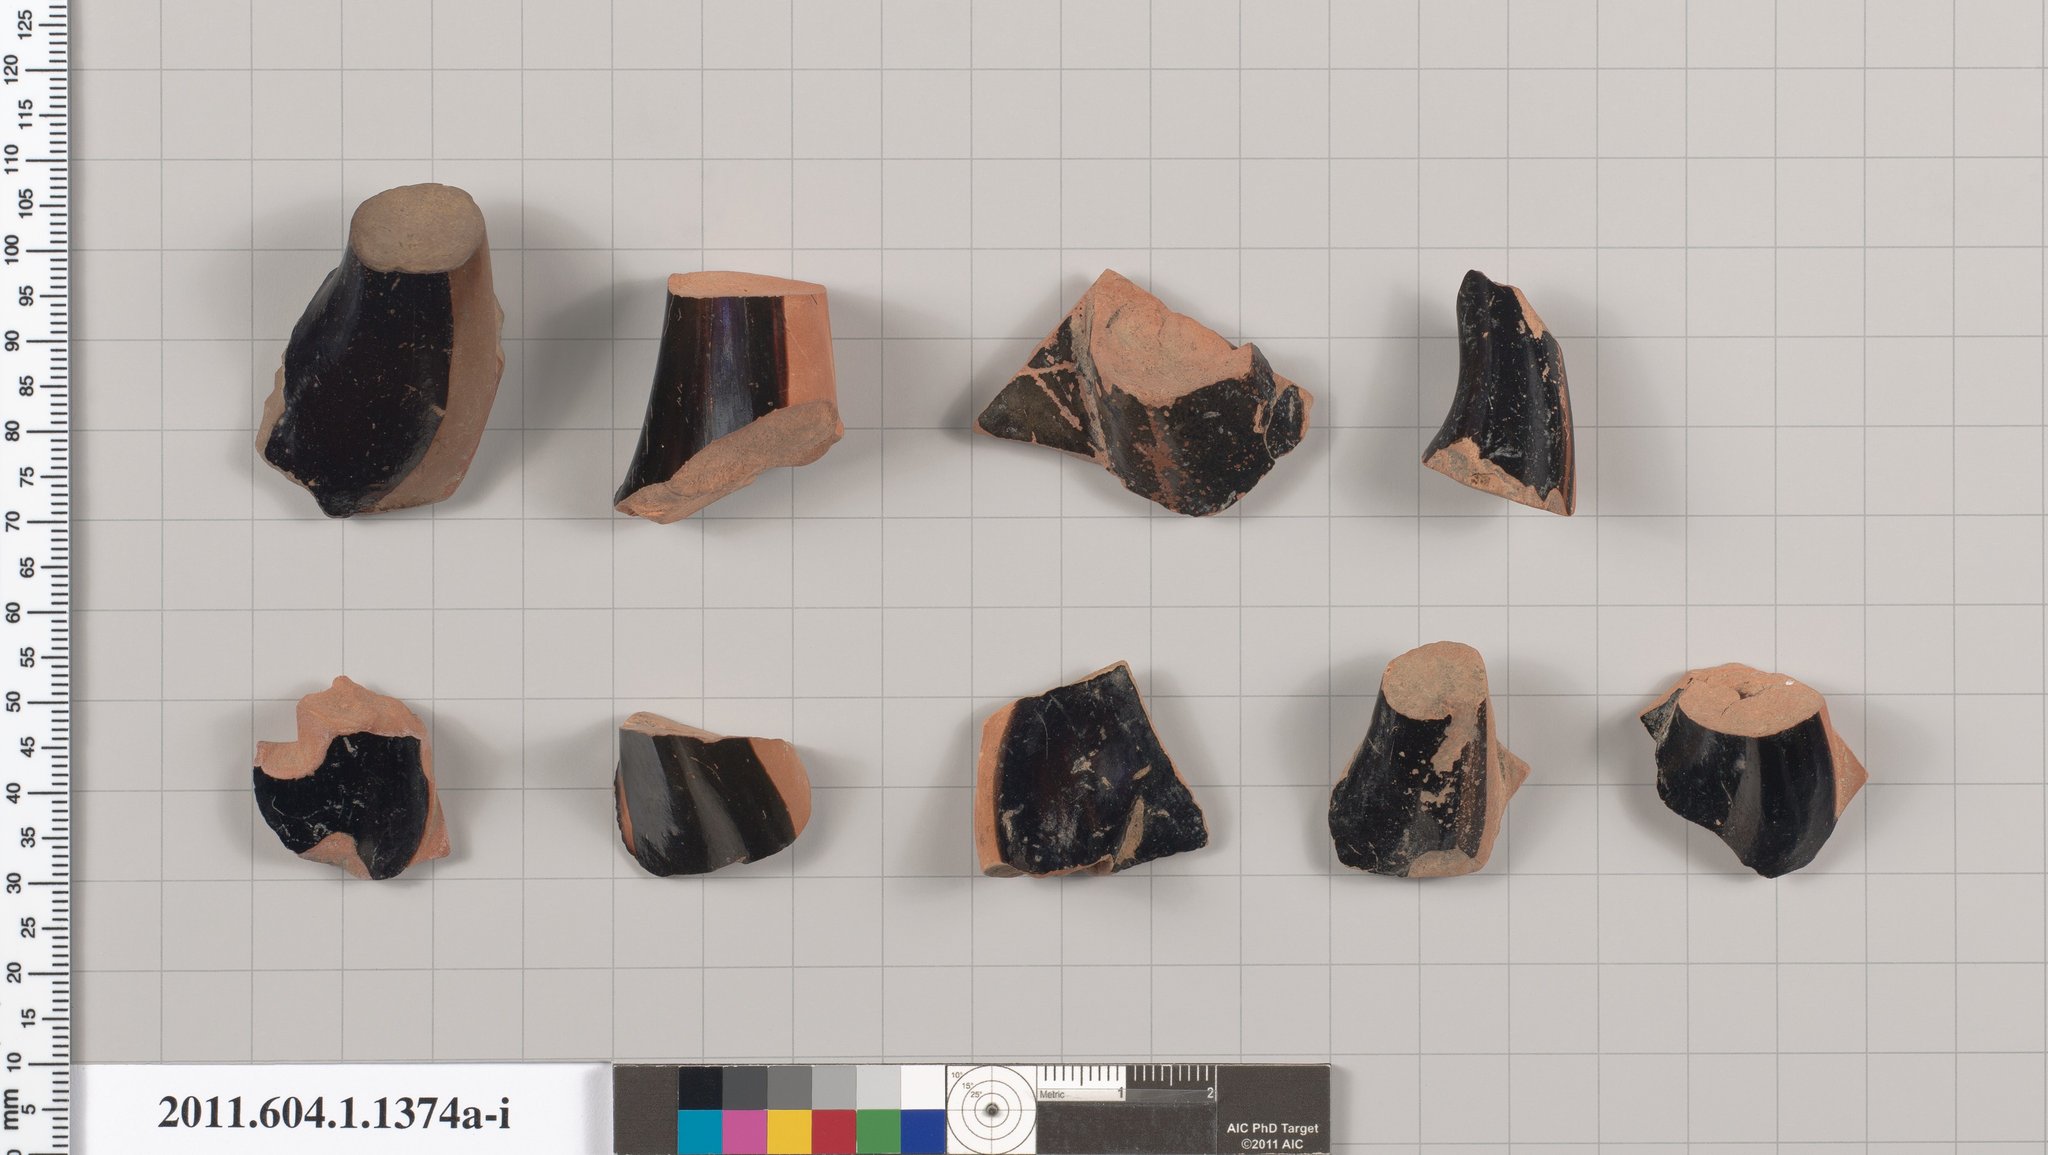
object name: kylix fragment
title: Terracotta fragments of kylikes (drinking cups)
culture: greek, attic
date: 500-401 BCE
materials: terracotta